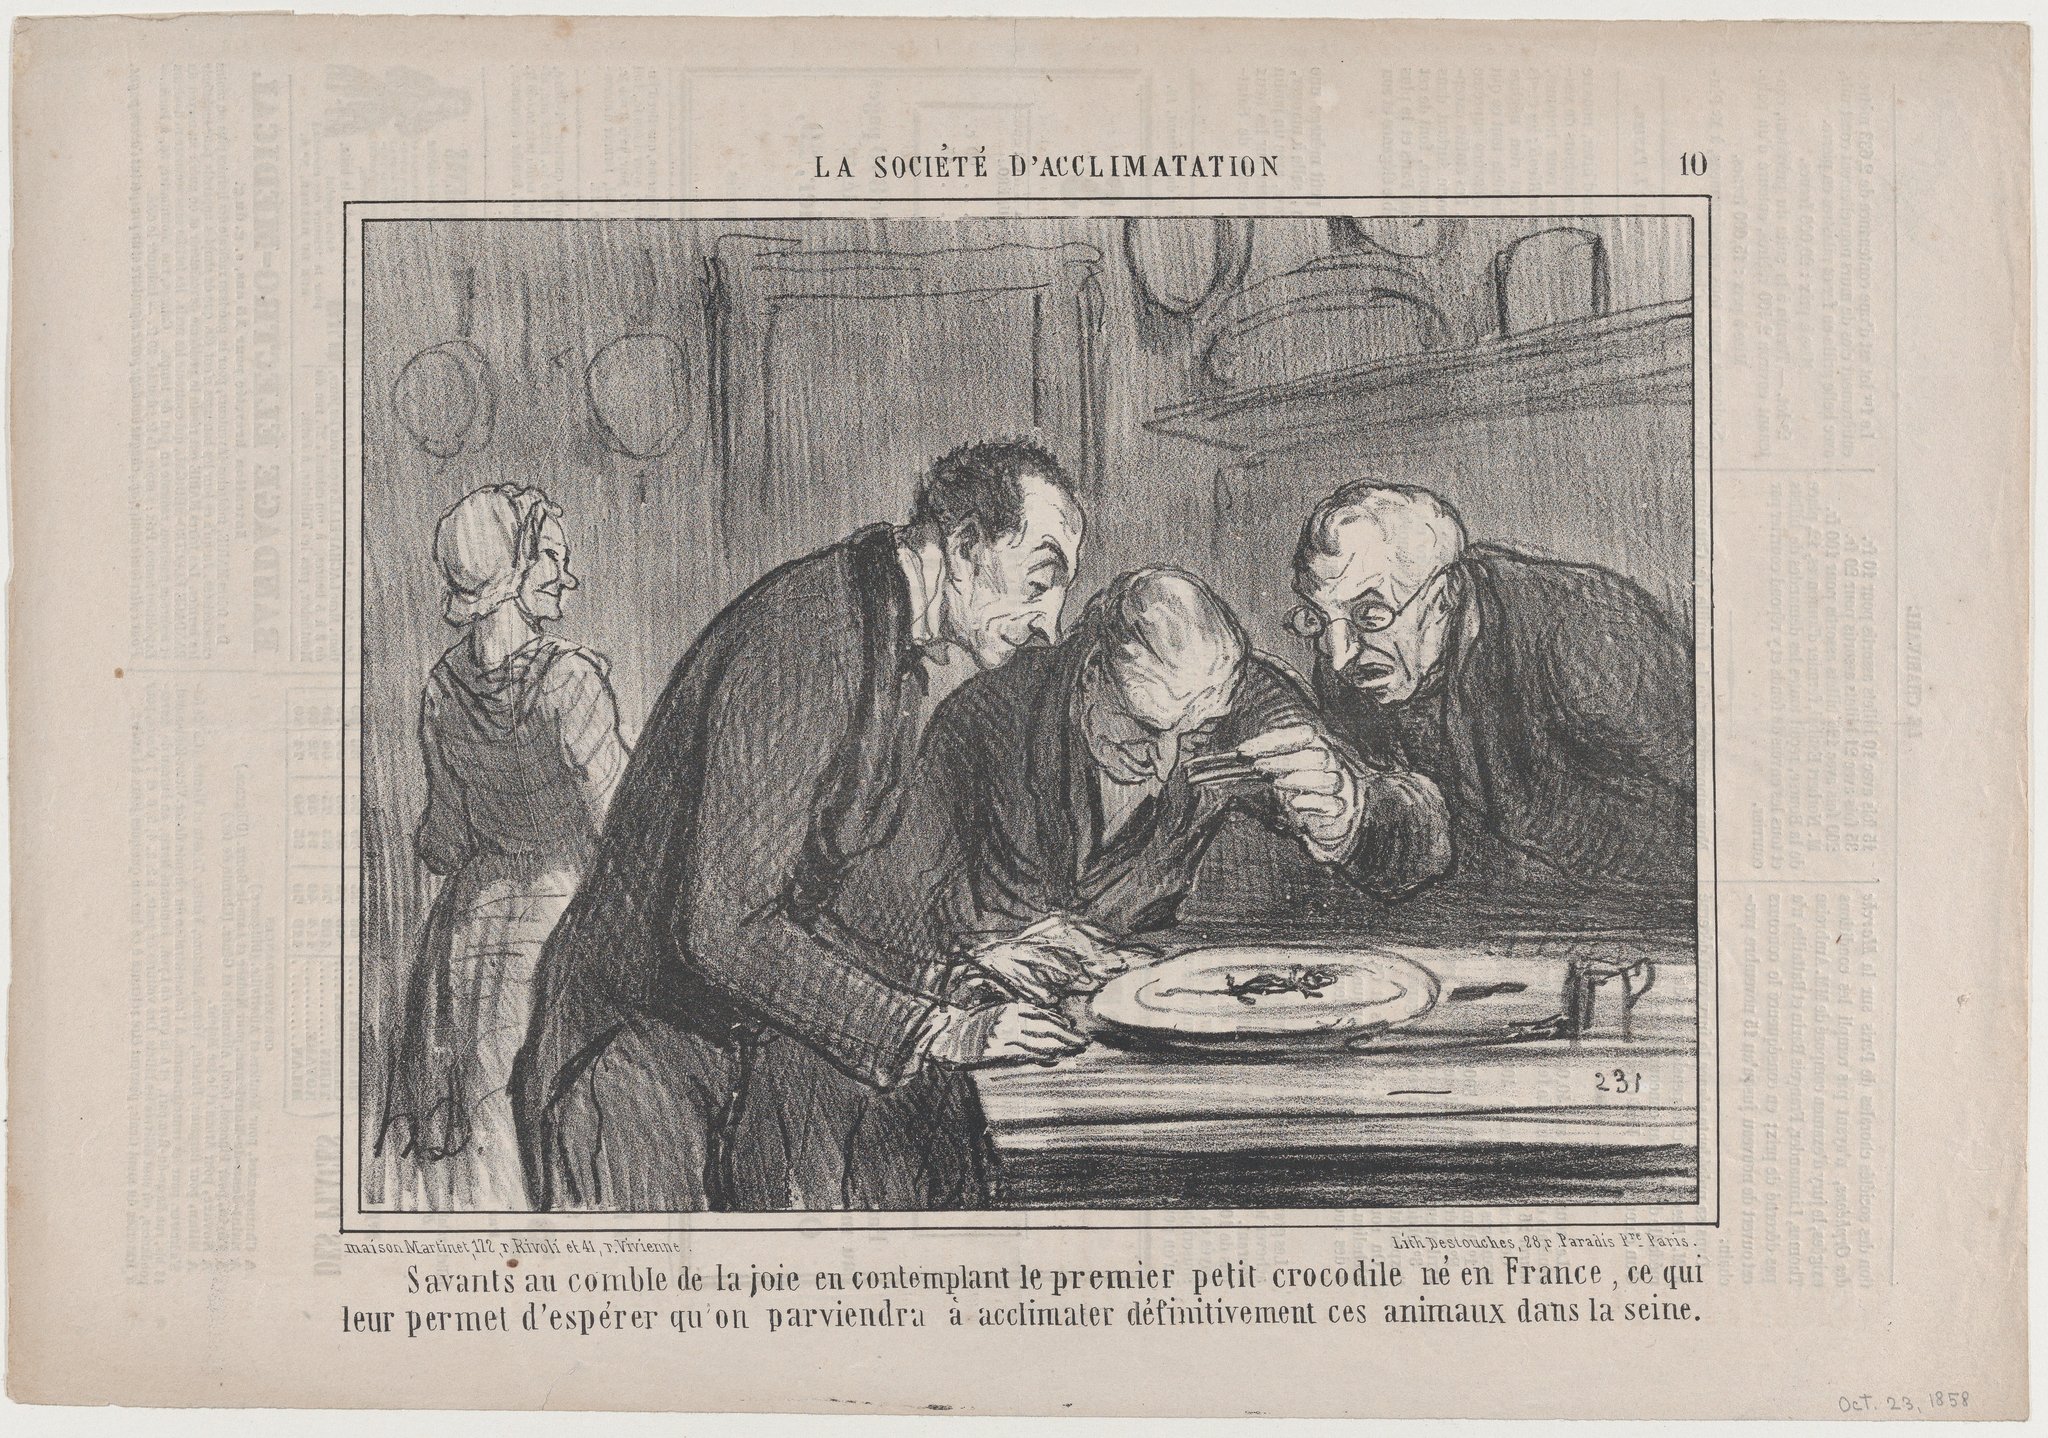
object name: print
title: Savants au comble de la joie en contemplant le premier petit crocodile né e France..., from La Société d'Acclimatations, published in Le Charivari, October 23, 1858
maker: honoré daumier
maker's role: artist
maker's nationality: french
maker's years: 1808-1879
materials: paper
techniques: lithograph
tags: men,women,crocodiles